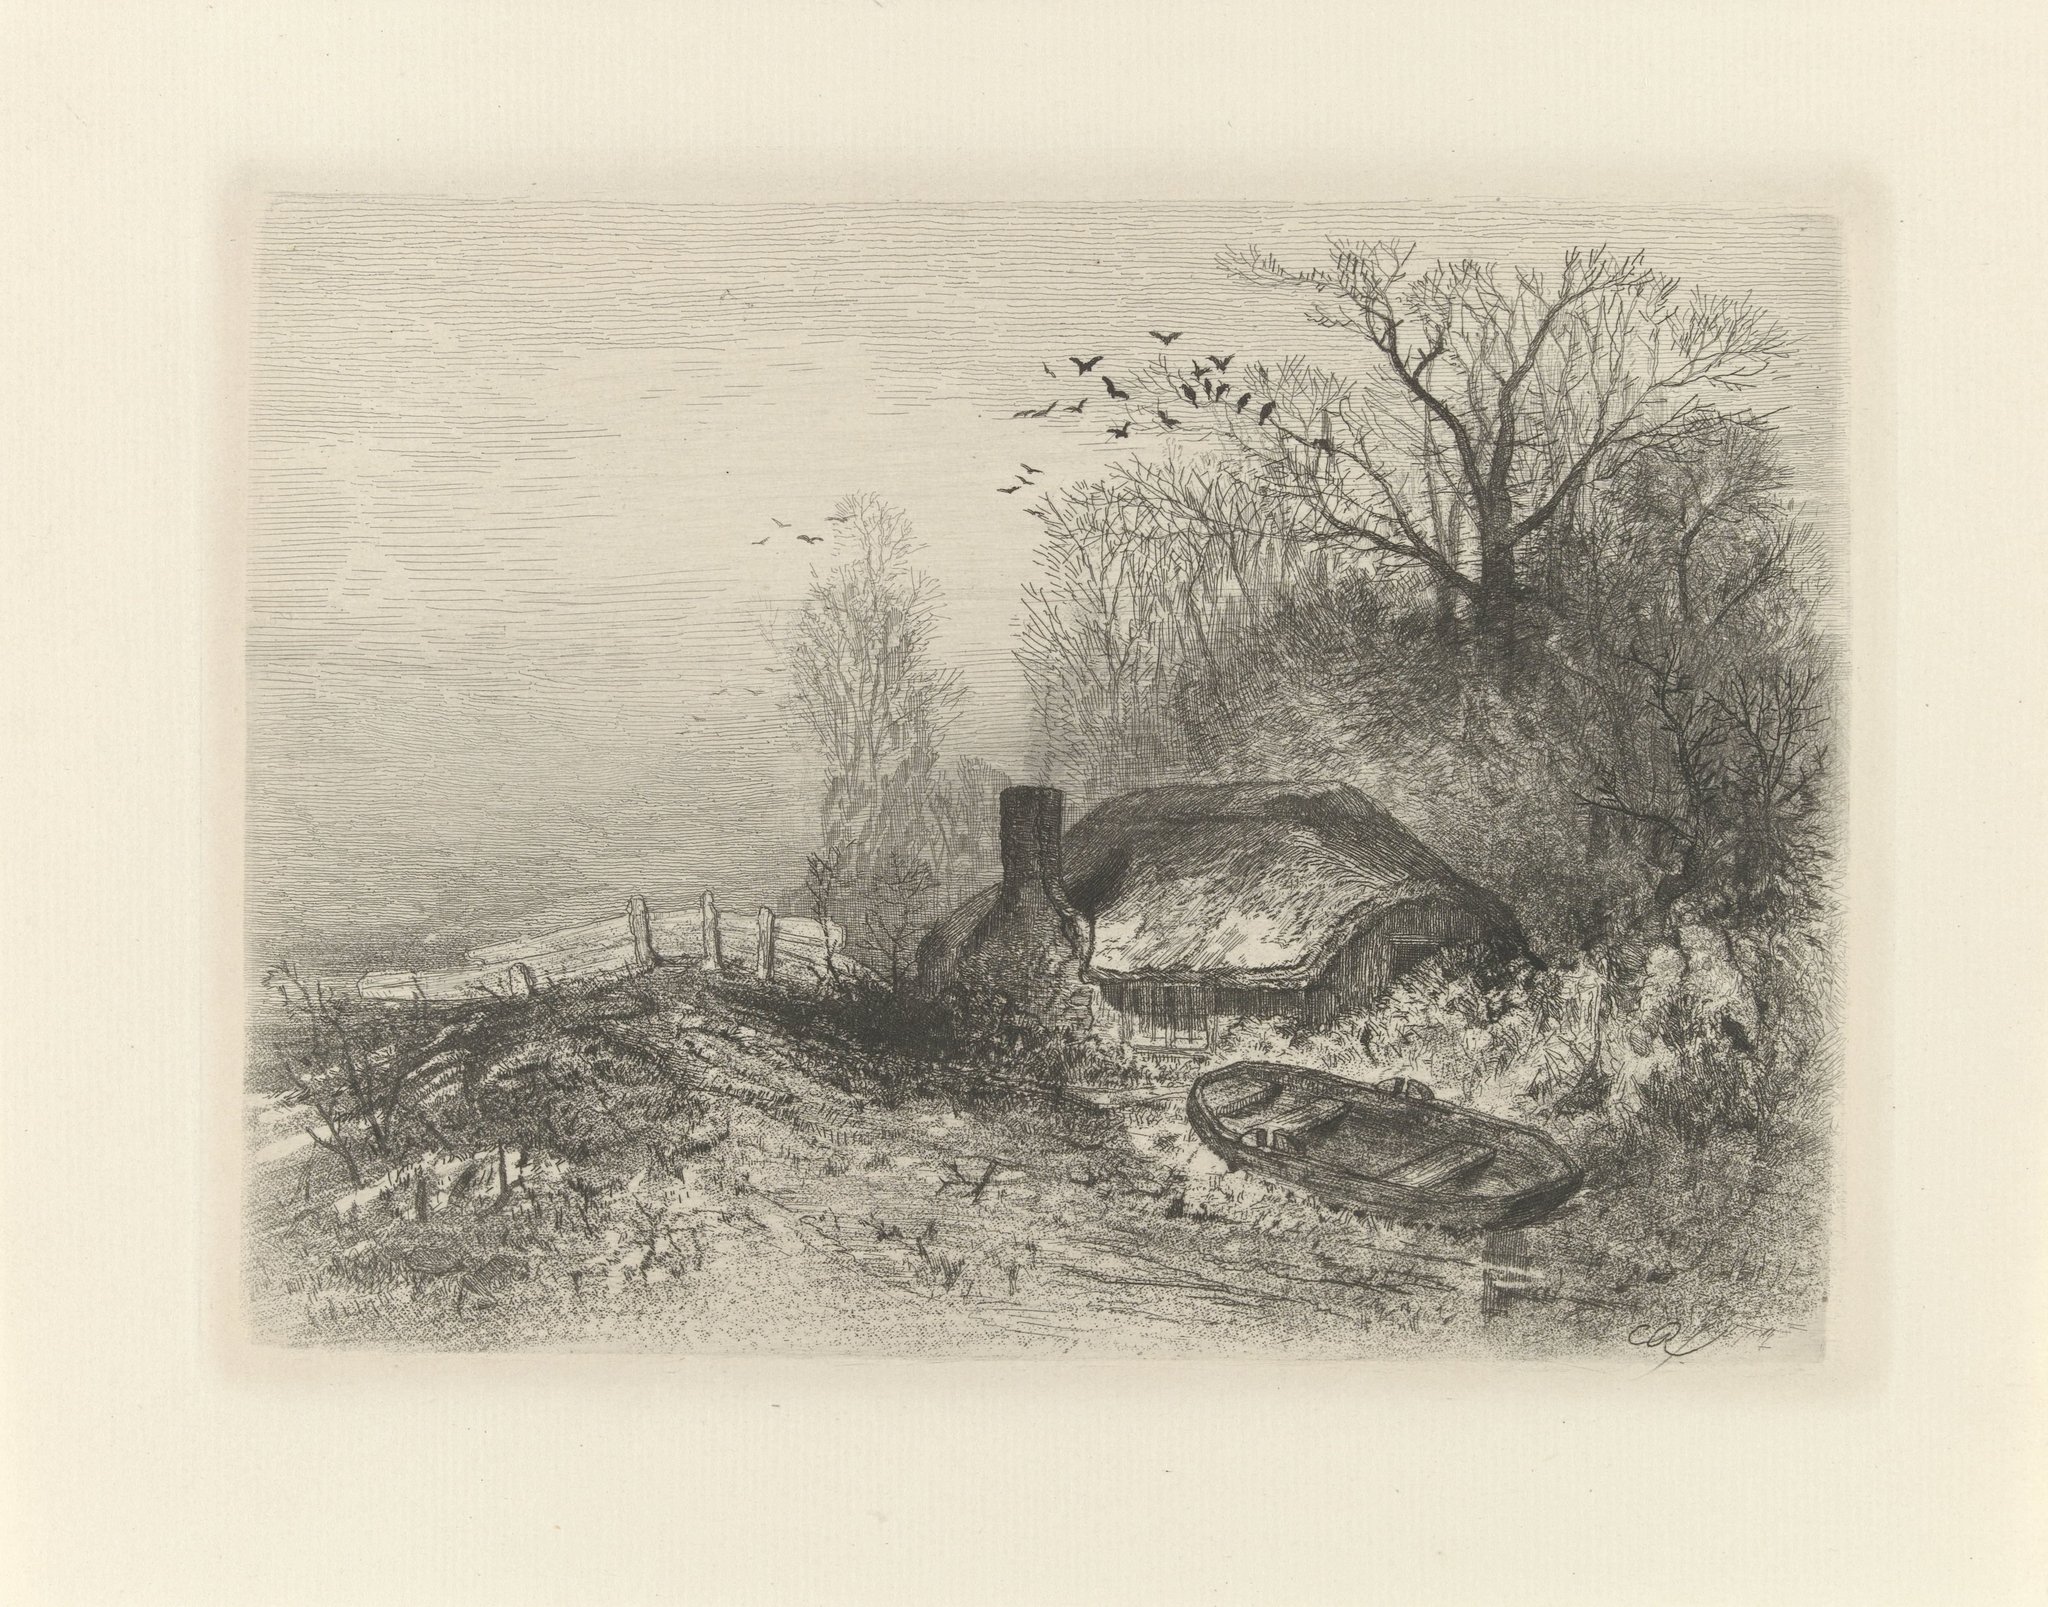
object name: print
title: Hut in een landschap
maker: charles rochussen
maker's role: draughtsman, painter, print maker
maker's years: 1814-1894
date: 1824-1879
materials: paper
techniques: etching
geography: netherlands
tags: rowing-boat, canoe, etc., farm or solitary house in landscape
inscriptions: collector's mark: Lugt 2228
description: Glooiend landschap met een hut en een boot. Boven de hut een groep vogels.